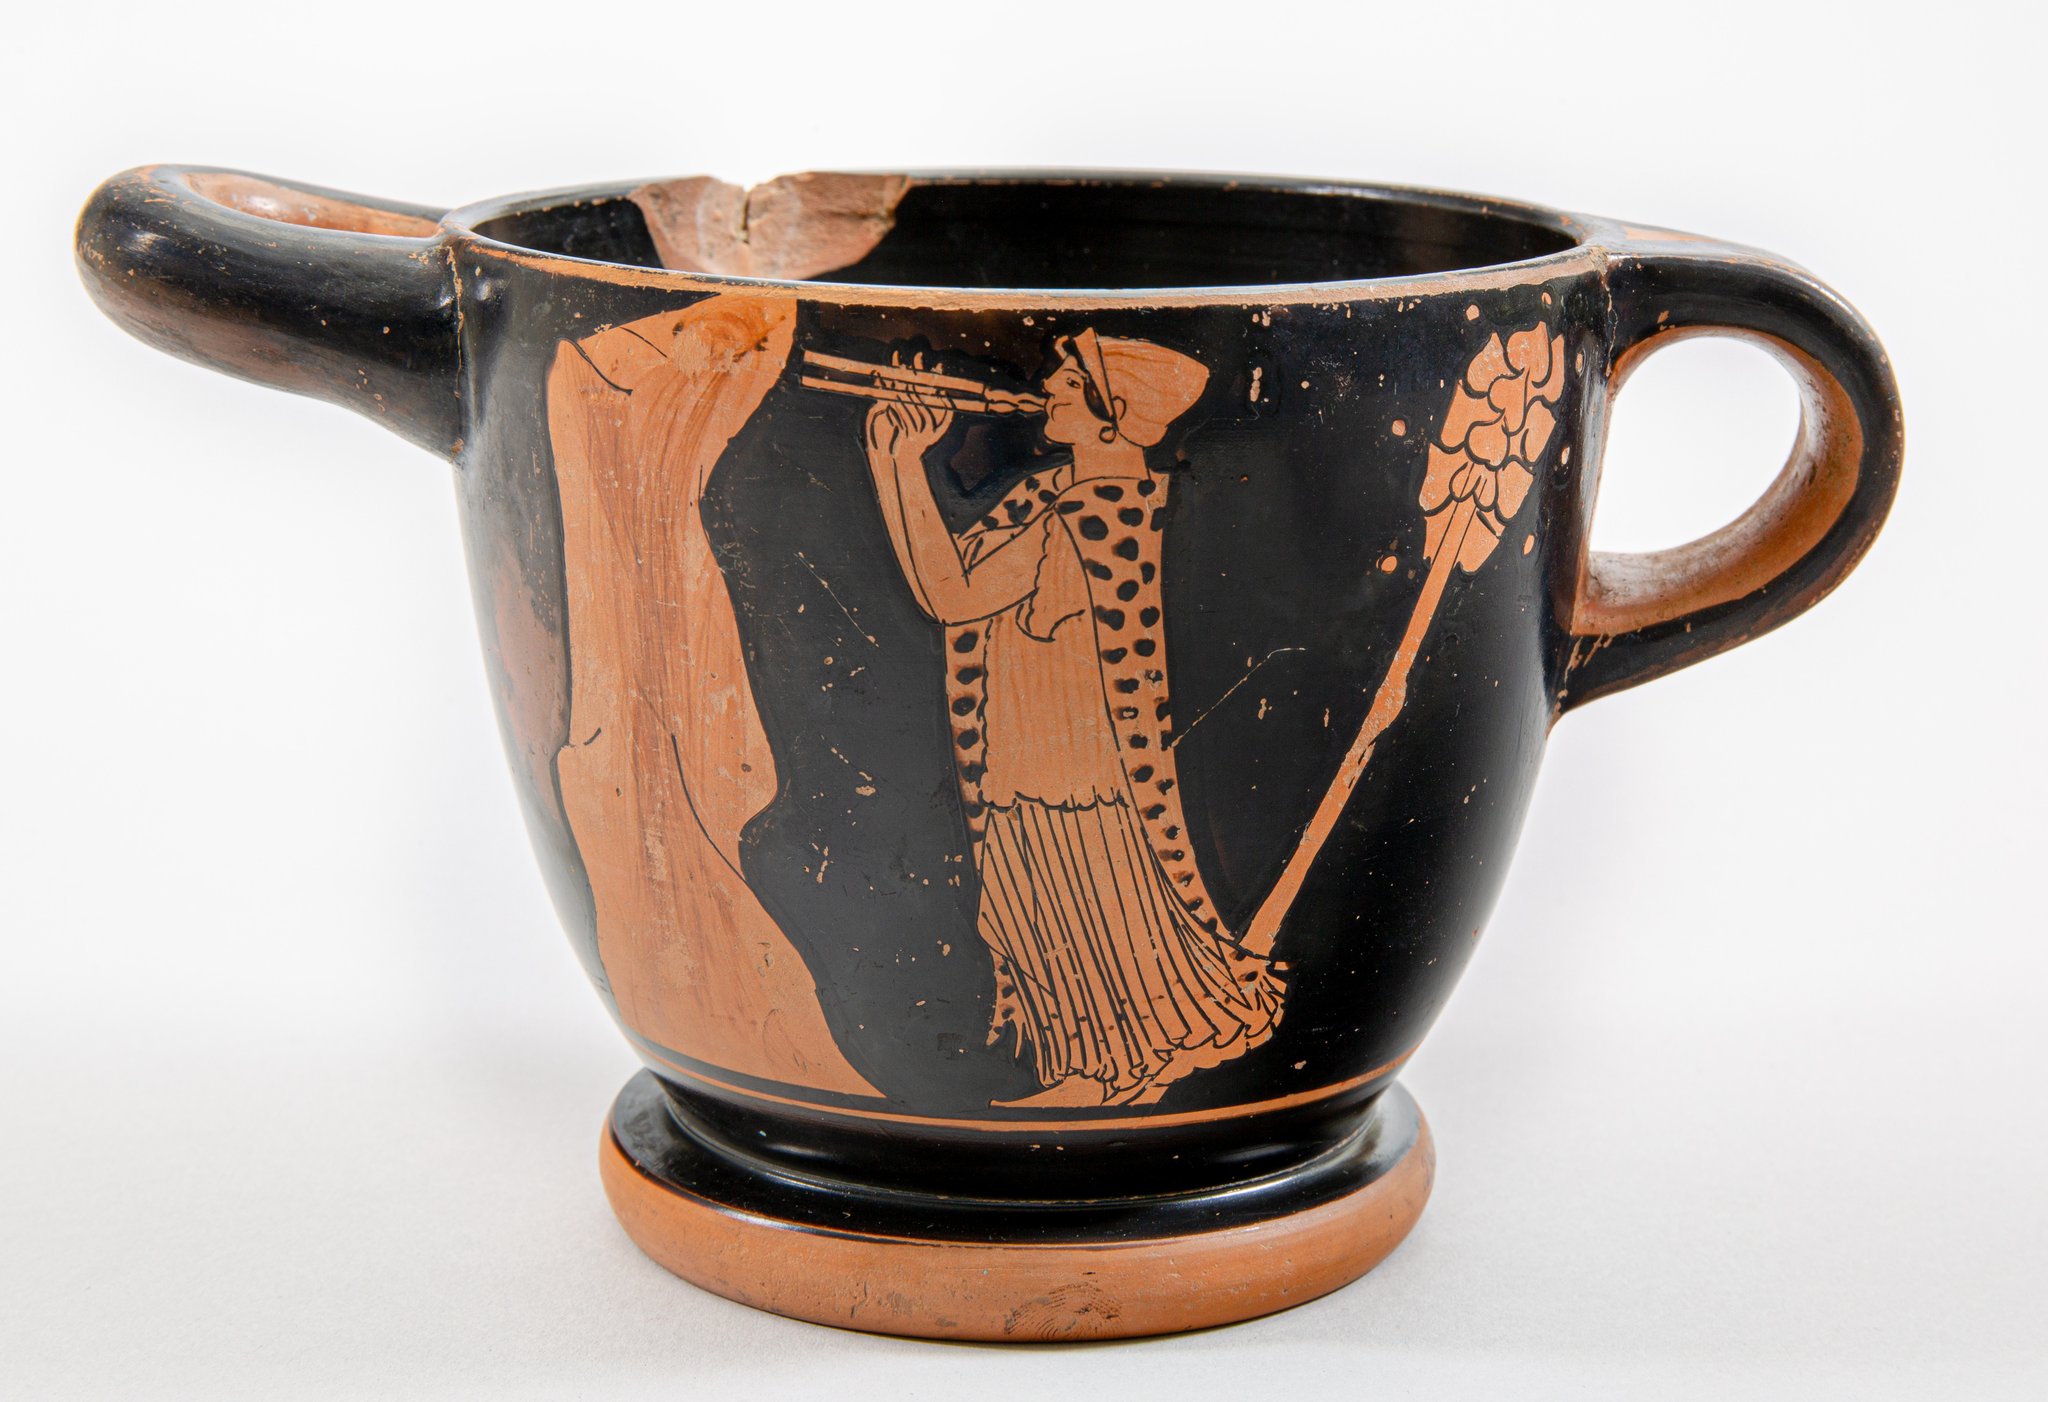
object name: skyphos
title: Terracotta skyphos (deep drinking cup)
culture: greek, attic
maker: brygos painter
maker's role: artist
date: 490-480 BCE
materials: terracotta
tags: maenads